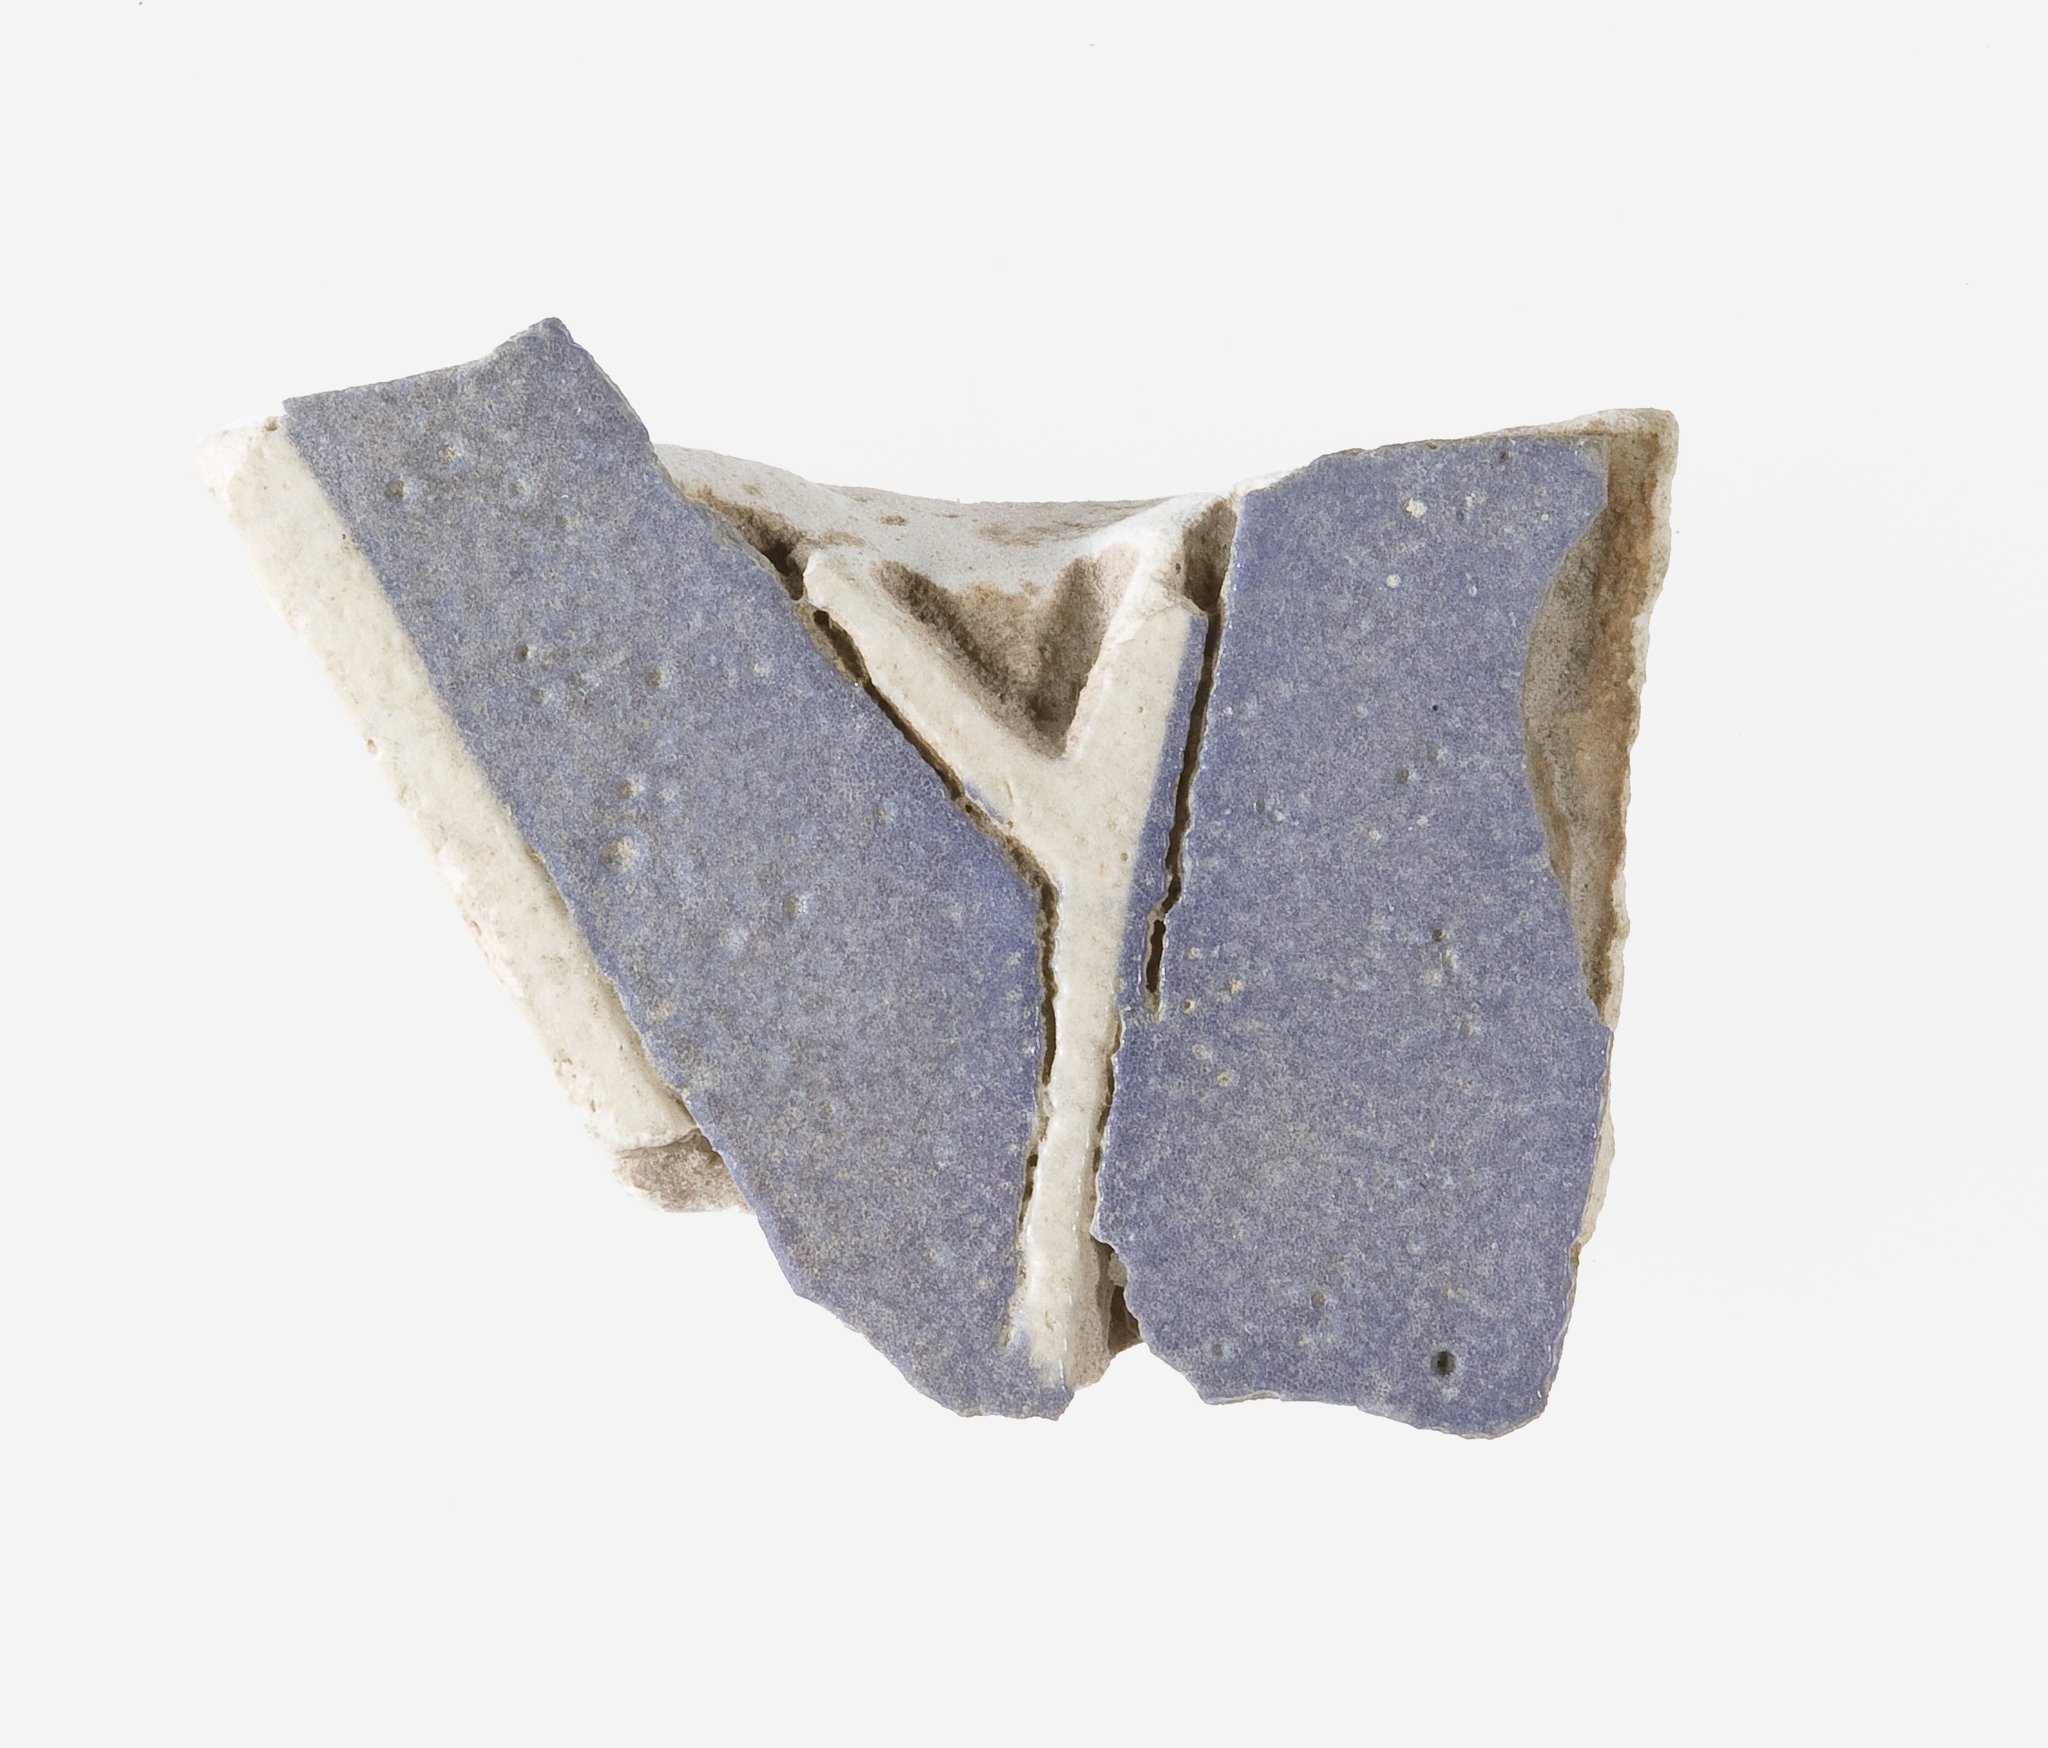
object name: necklace terminal, lotus collar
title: Fragment of Lotus Collar Terminals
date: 1390-1352 BCE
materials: faience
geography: egypt